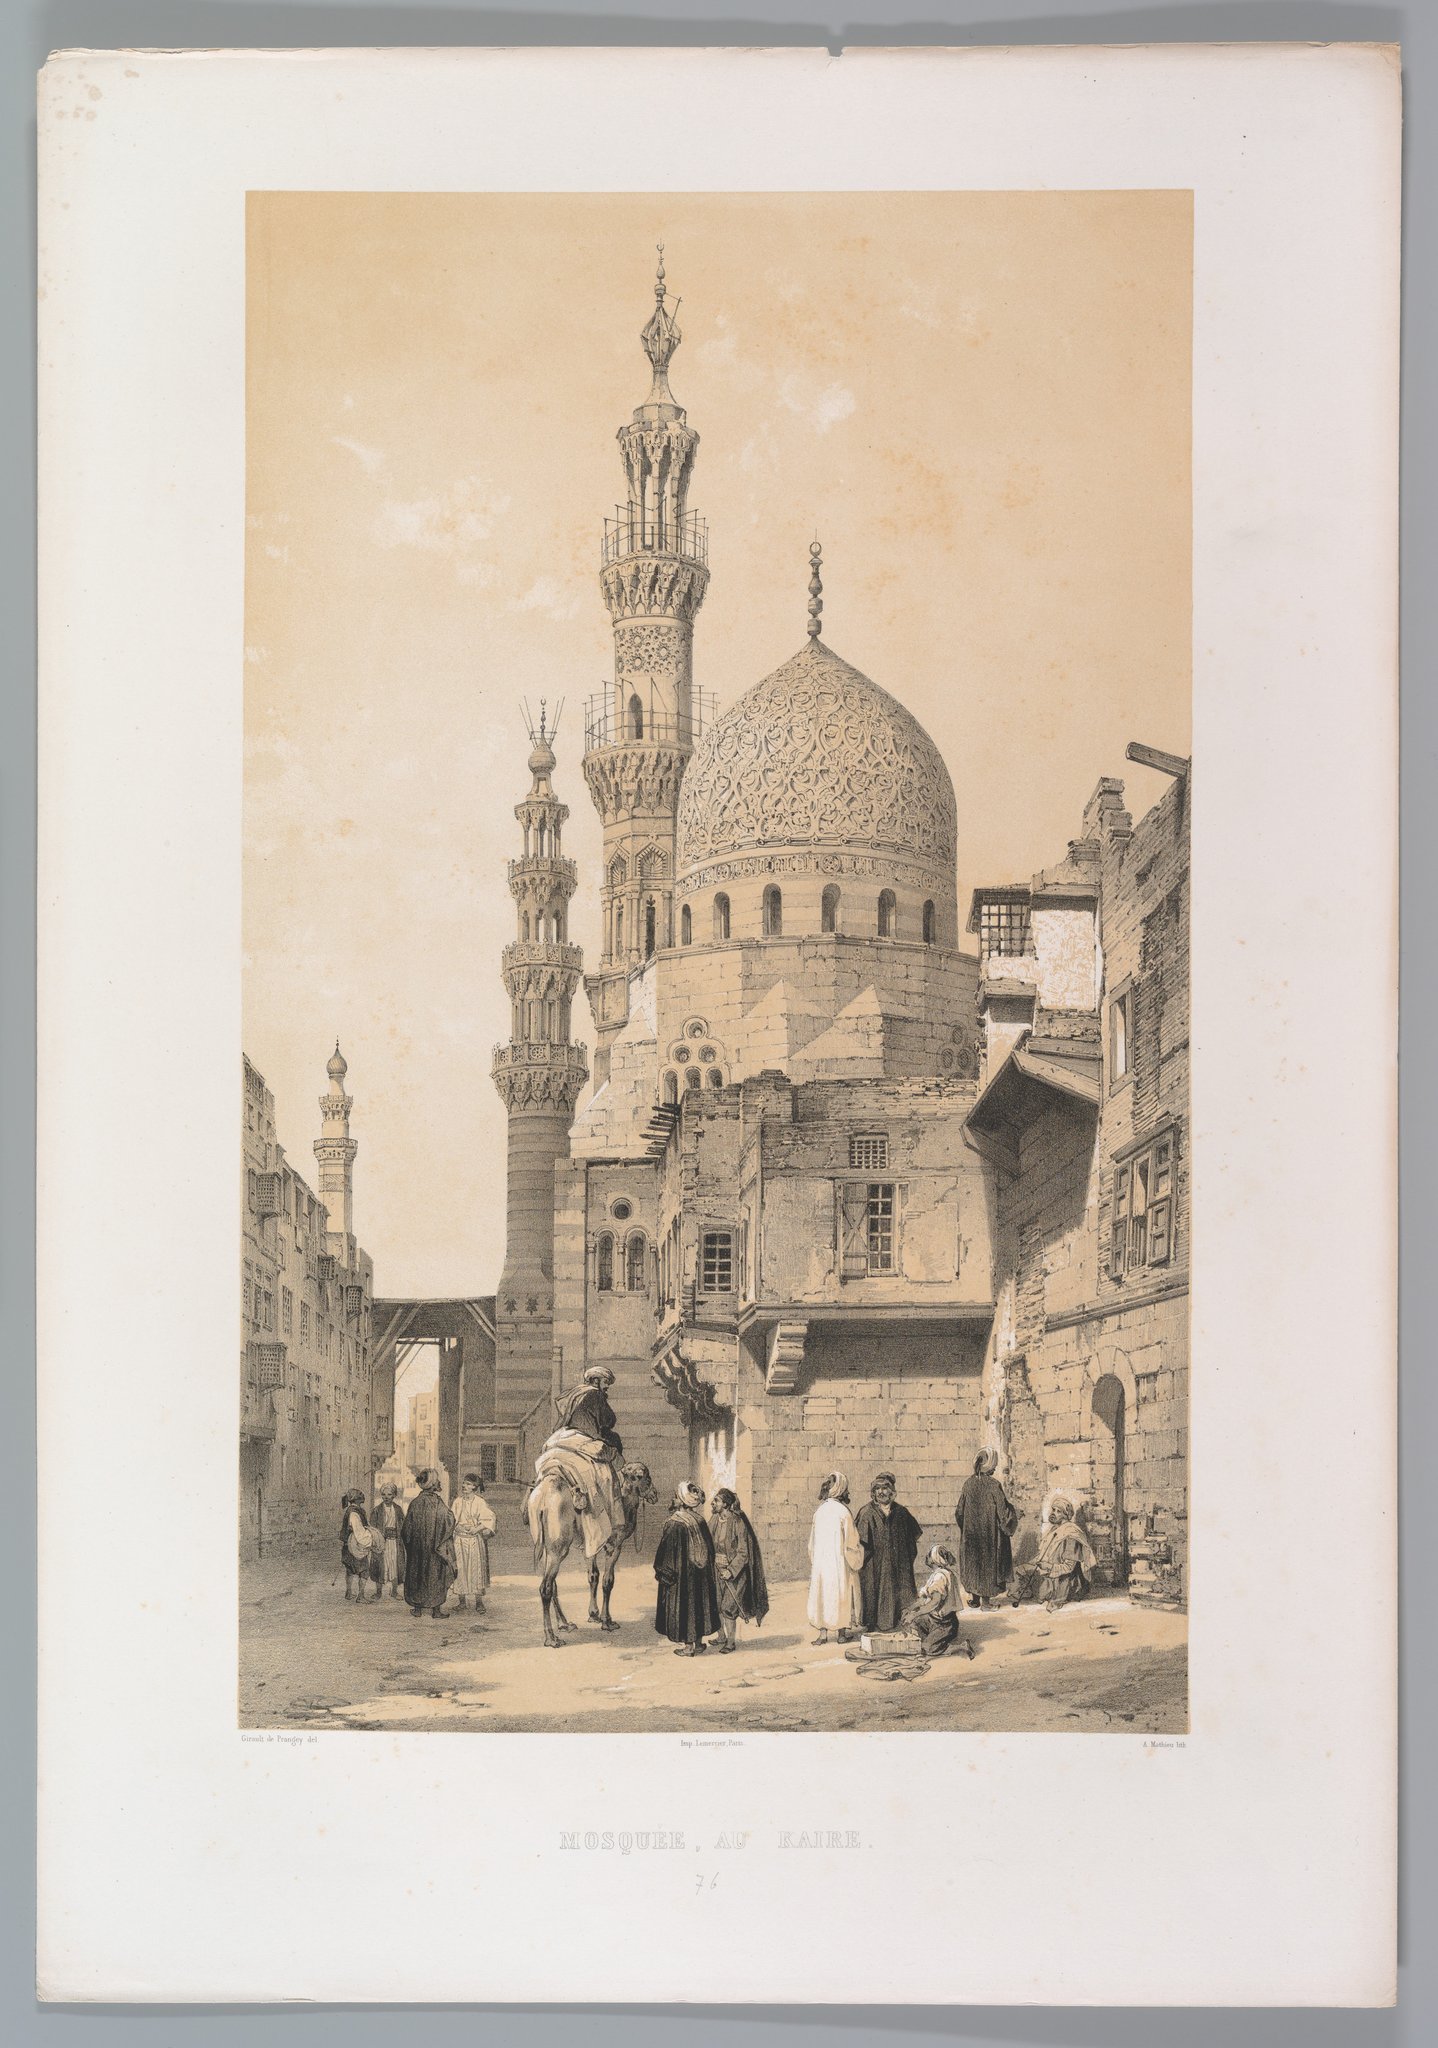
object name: lithograph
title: Mosquée, au Kaire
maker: joseph-philibert girault de prangey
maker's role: artist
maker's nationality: french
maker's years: 1804-1892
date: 1843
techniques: lithograph